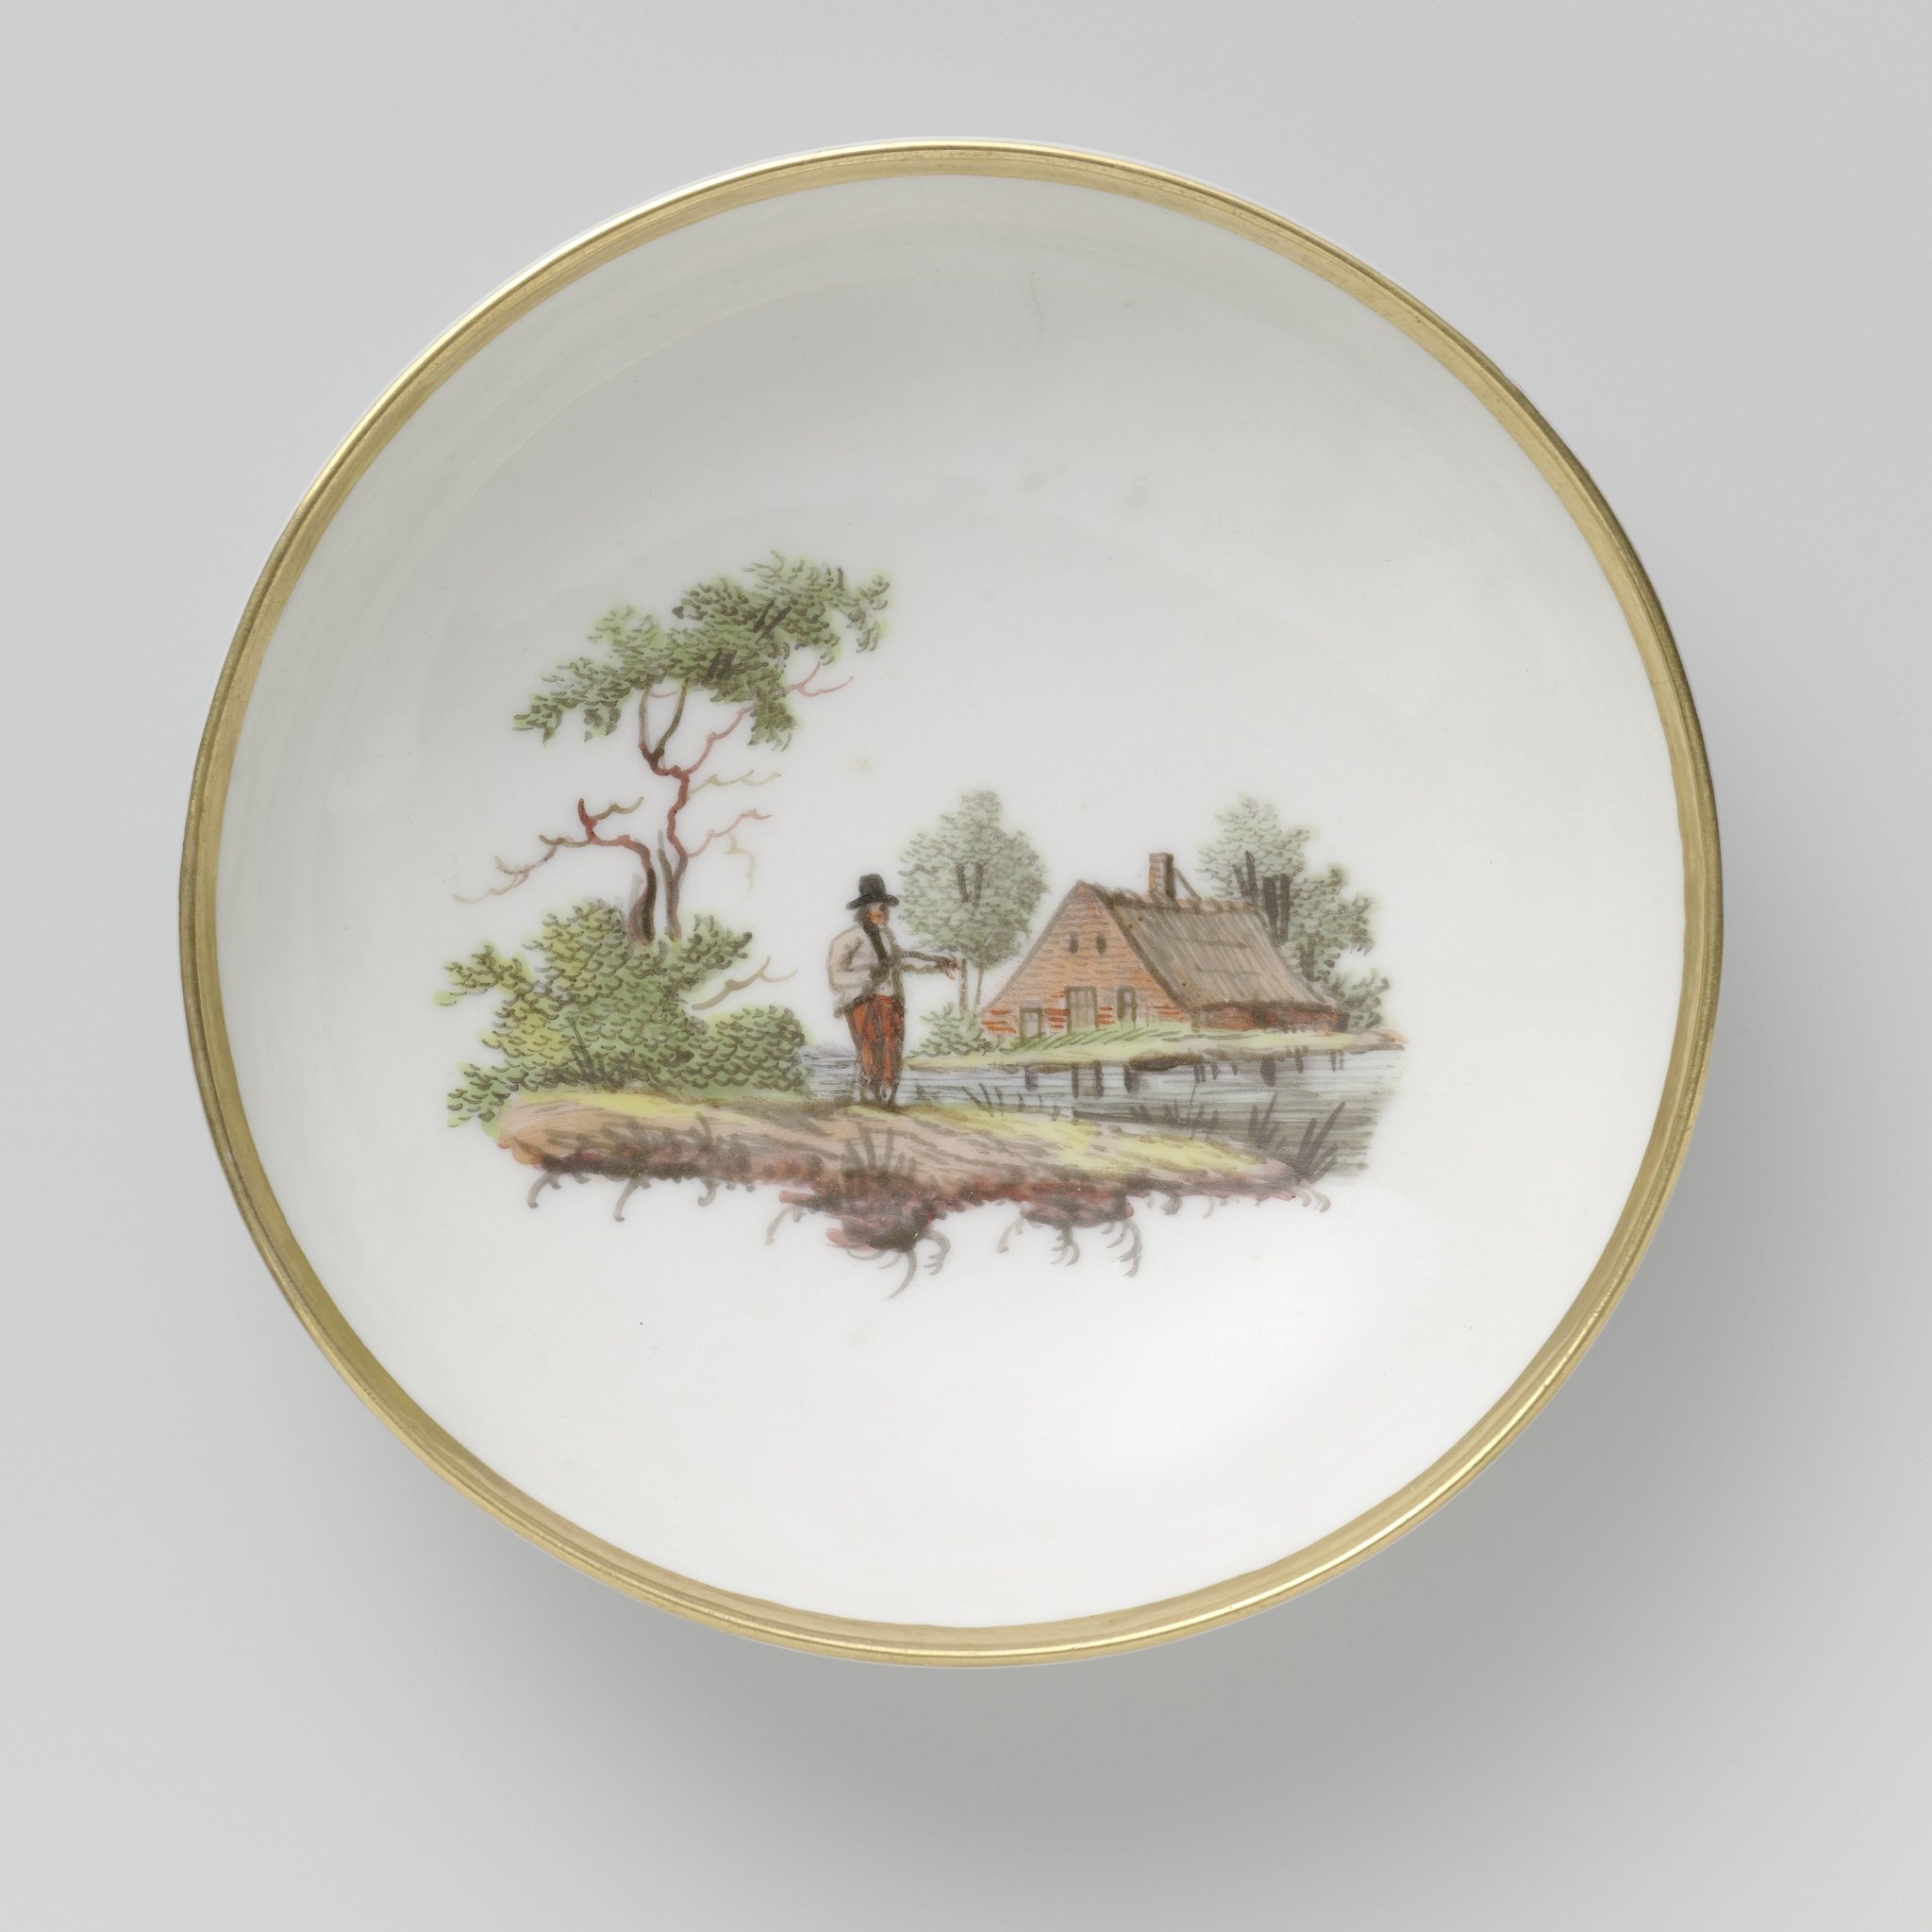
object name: kop en schotel, kop en schotel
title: Kop en schotel met riviergezicht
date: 1809-1814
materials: porcelain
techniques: painted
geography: nieuwer-amstel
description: Kop en schotel versierd met een veelkleurig landschap. Langs de randen een bladrank. Gemerkt: Amstel.